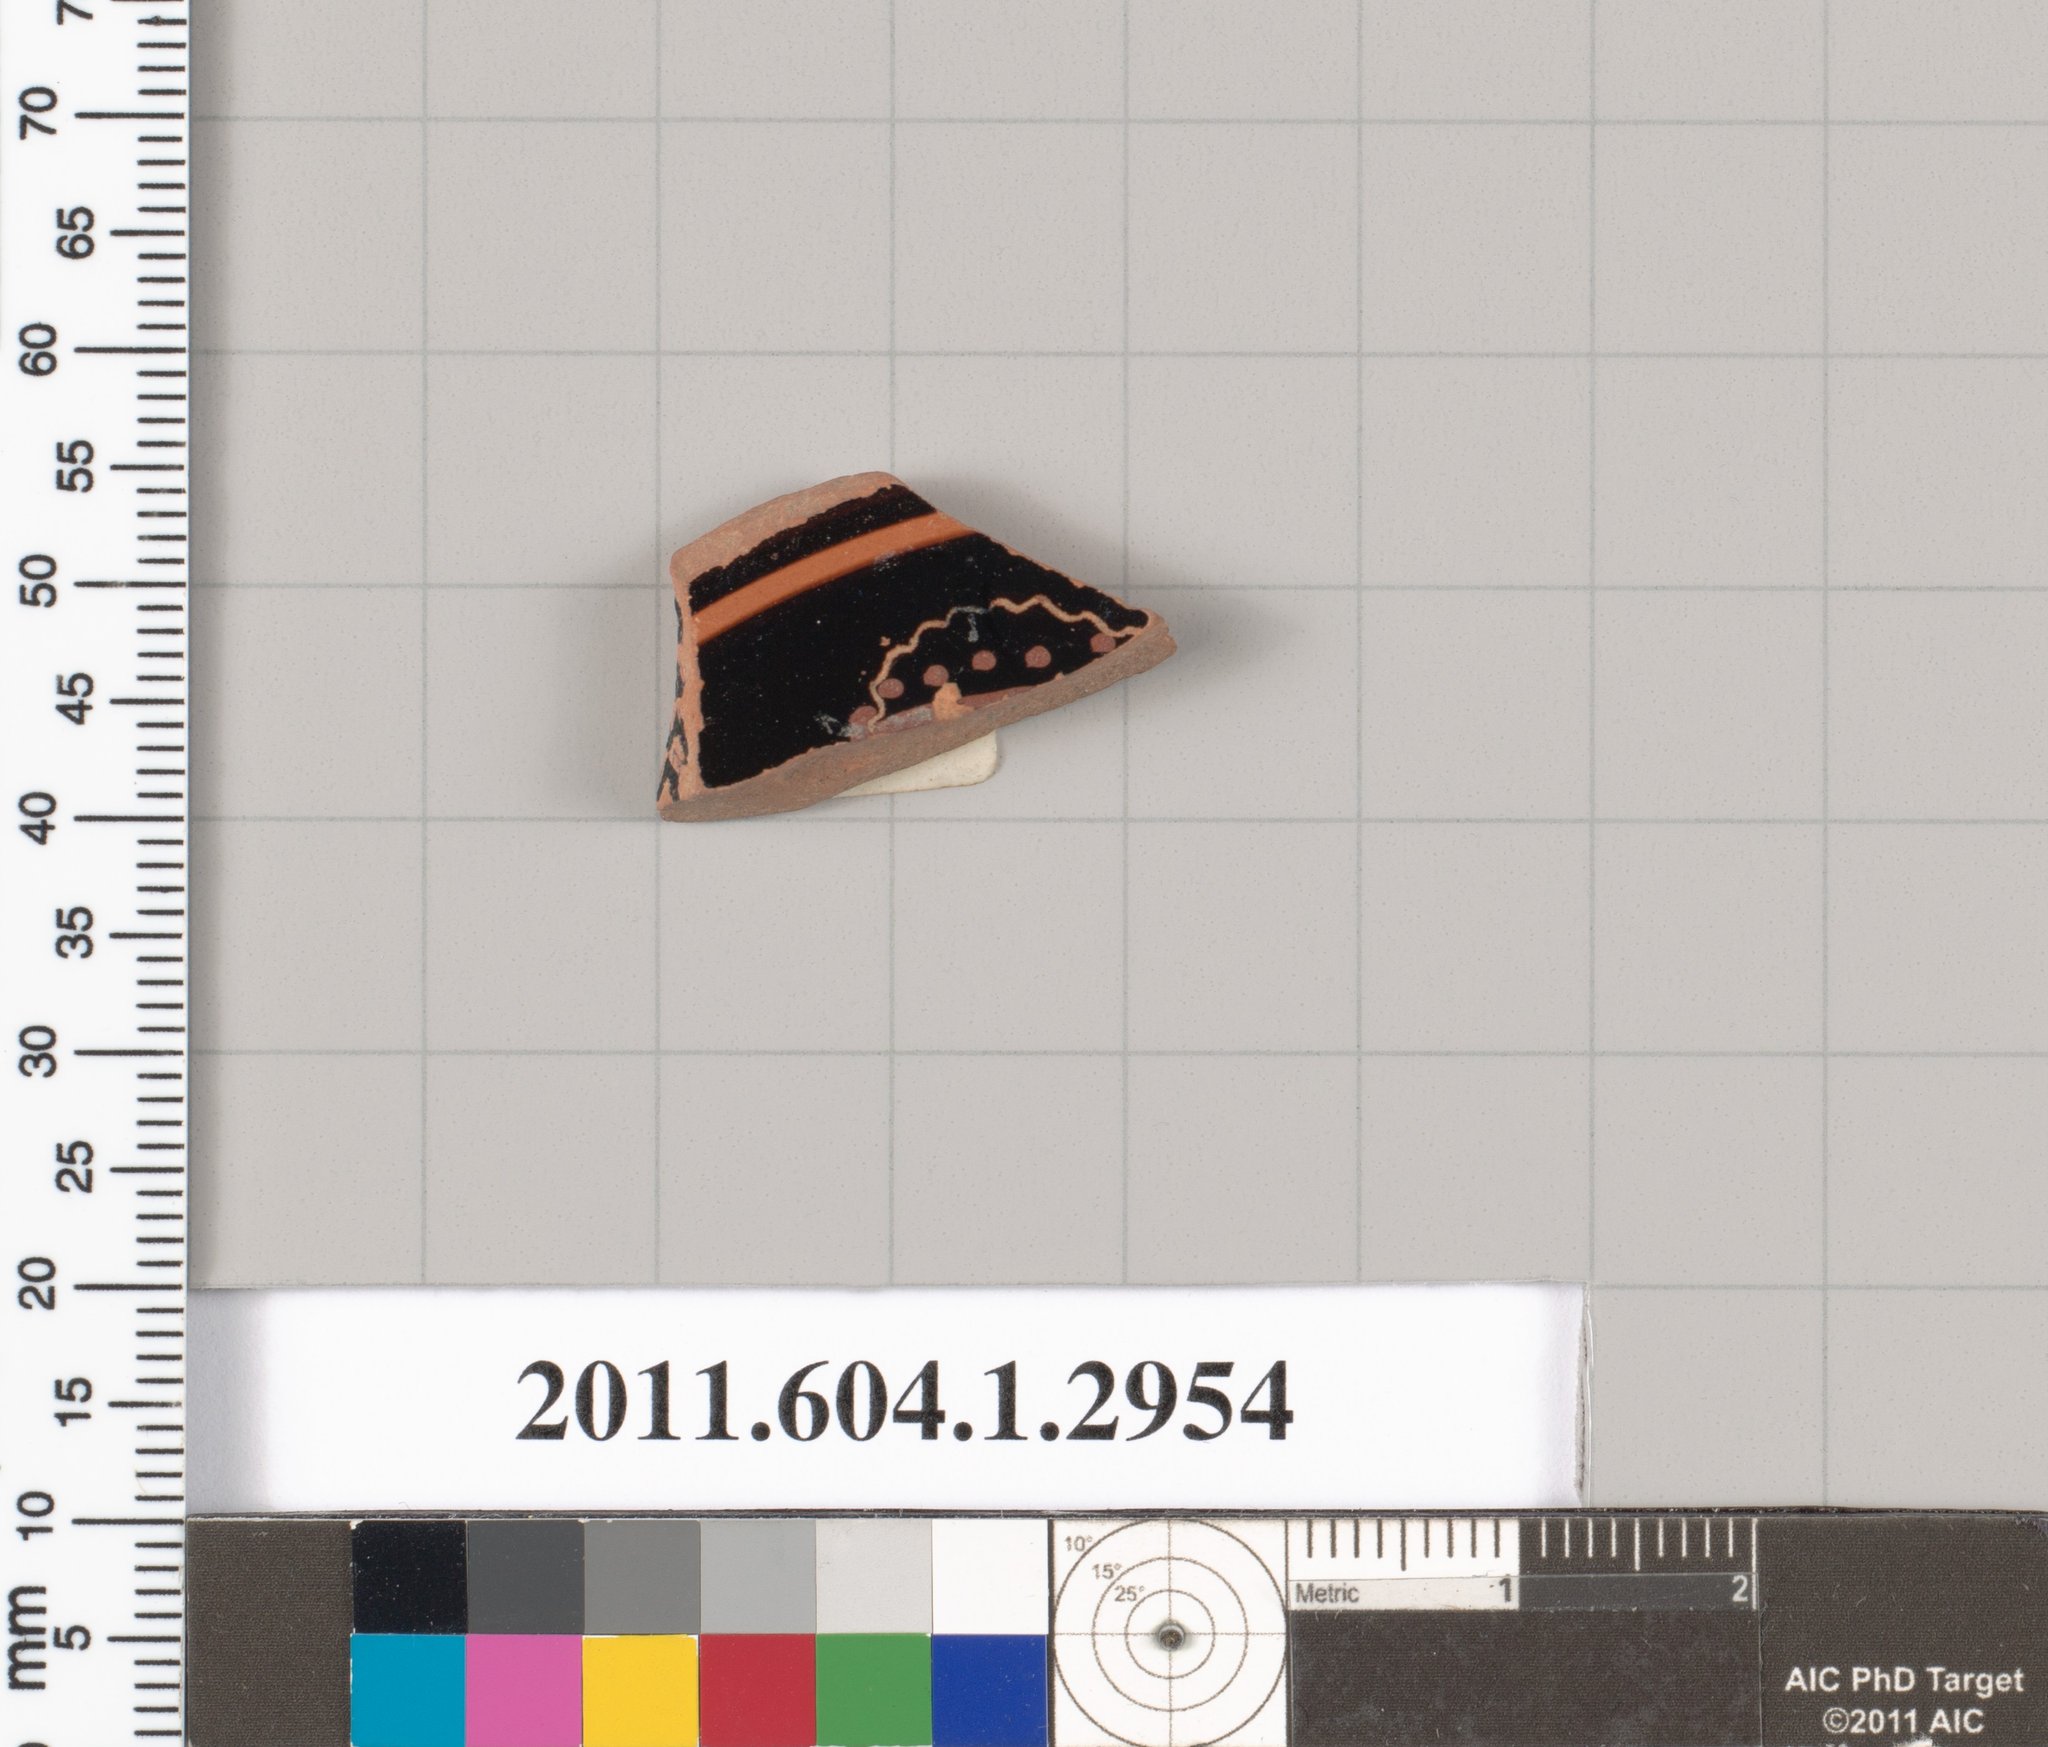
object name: kylix fragment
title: Terracotta fragment of a kylix (drinking cup)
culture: greek, attic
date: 520-500 BCE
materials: terracotta